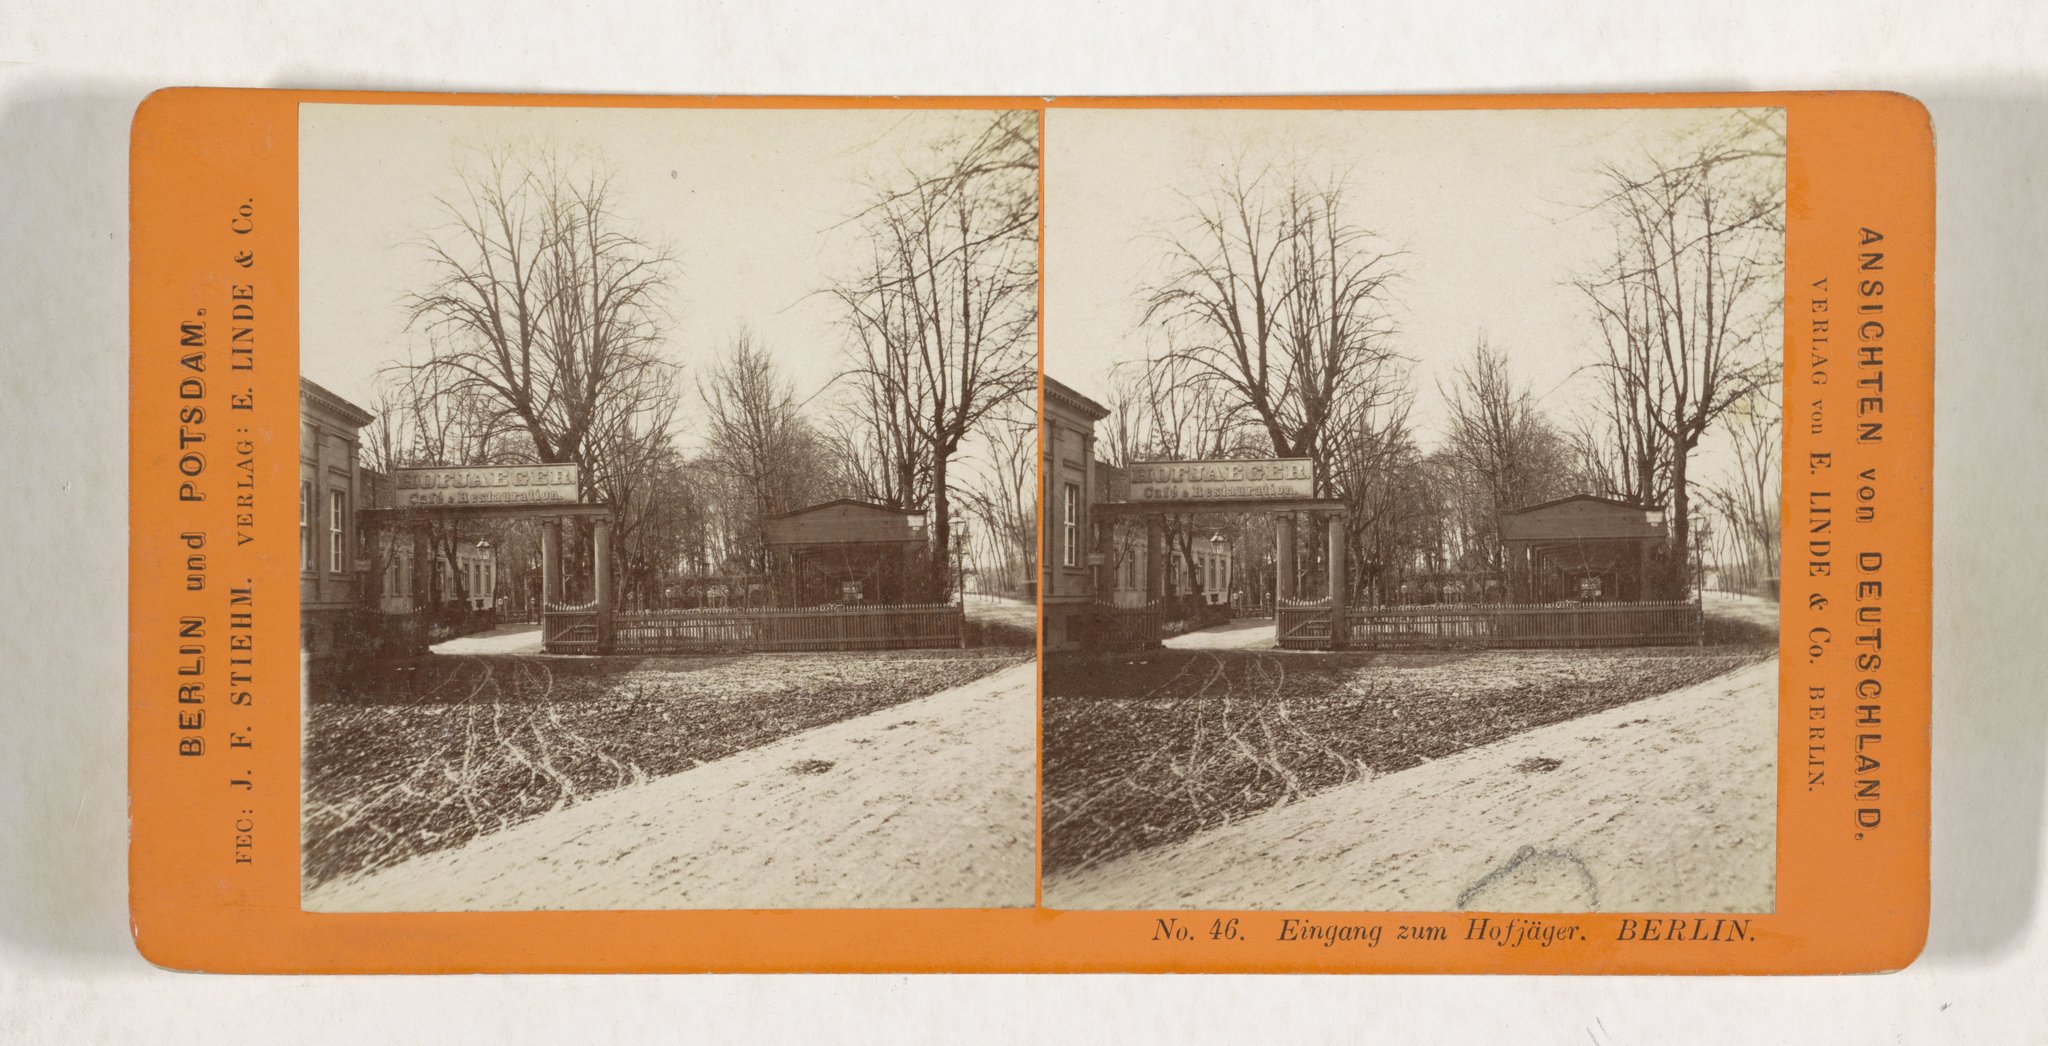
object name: stereograph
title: Ansichten von Deutschland / Berlin und Potsdam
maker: johann friedrich stiehm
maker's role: fotograaf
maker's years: 1826-1902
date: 1868-1870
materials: cardboard, paper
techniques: albumen print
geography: berlin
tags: tea garden, garden restaurant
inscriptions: number: ‘No. 46.’